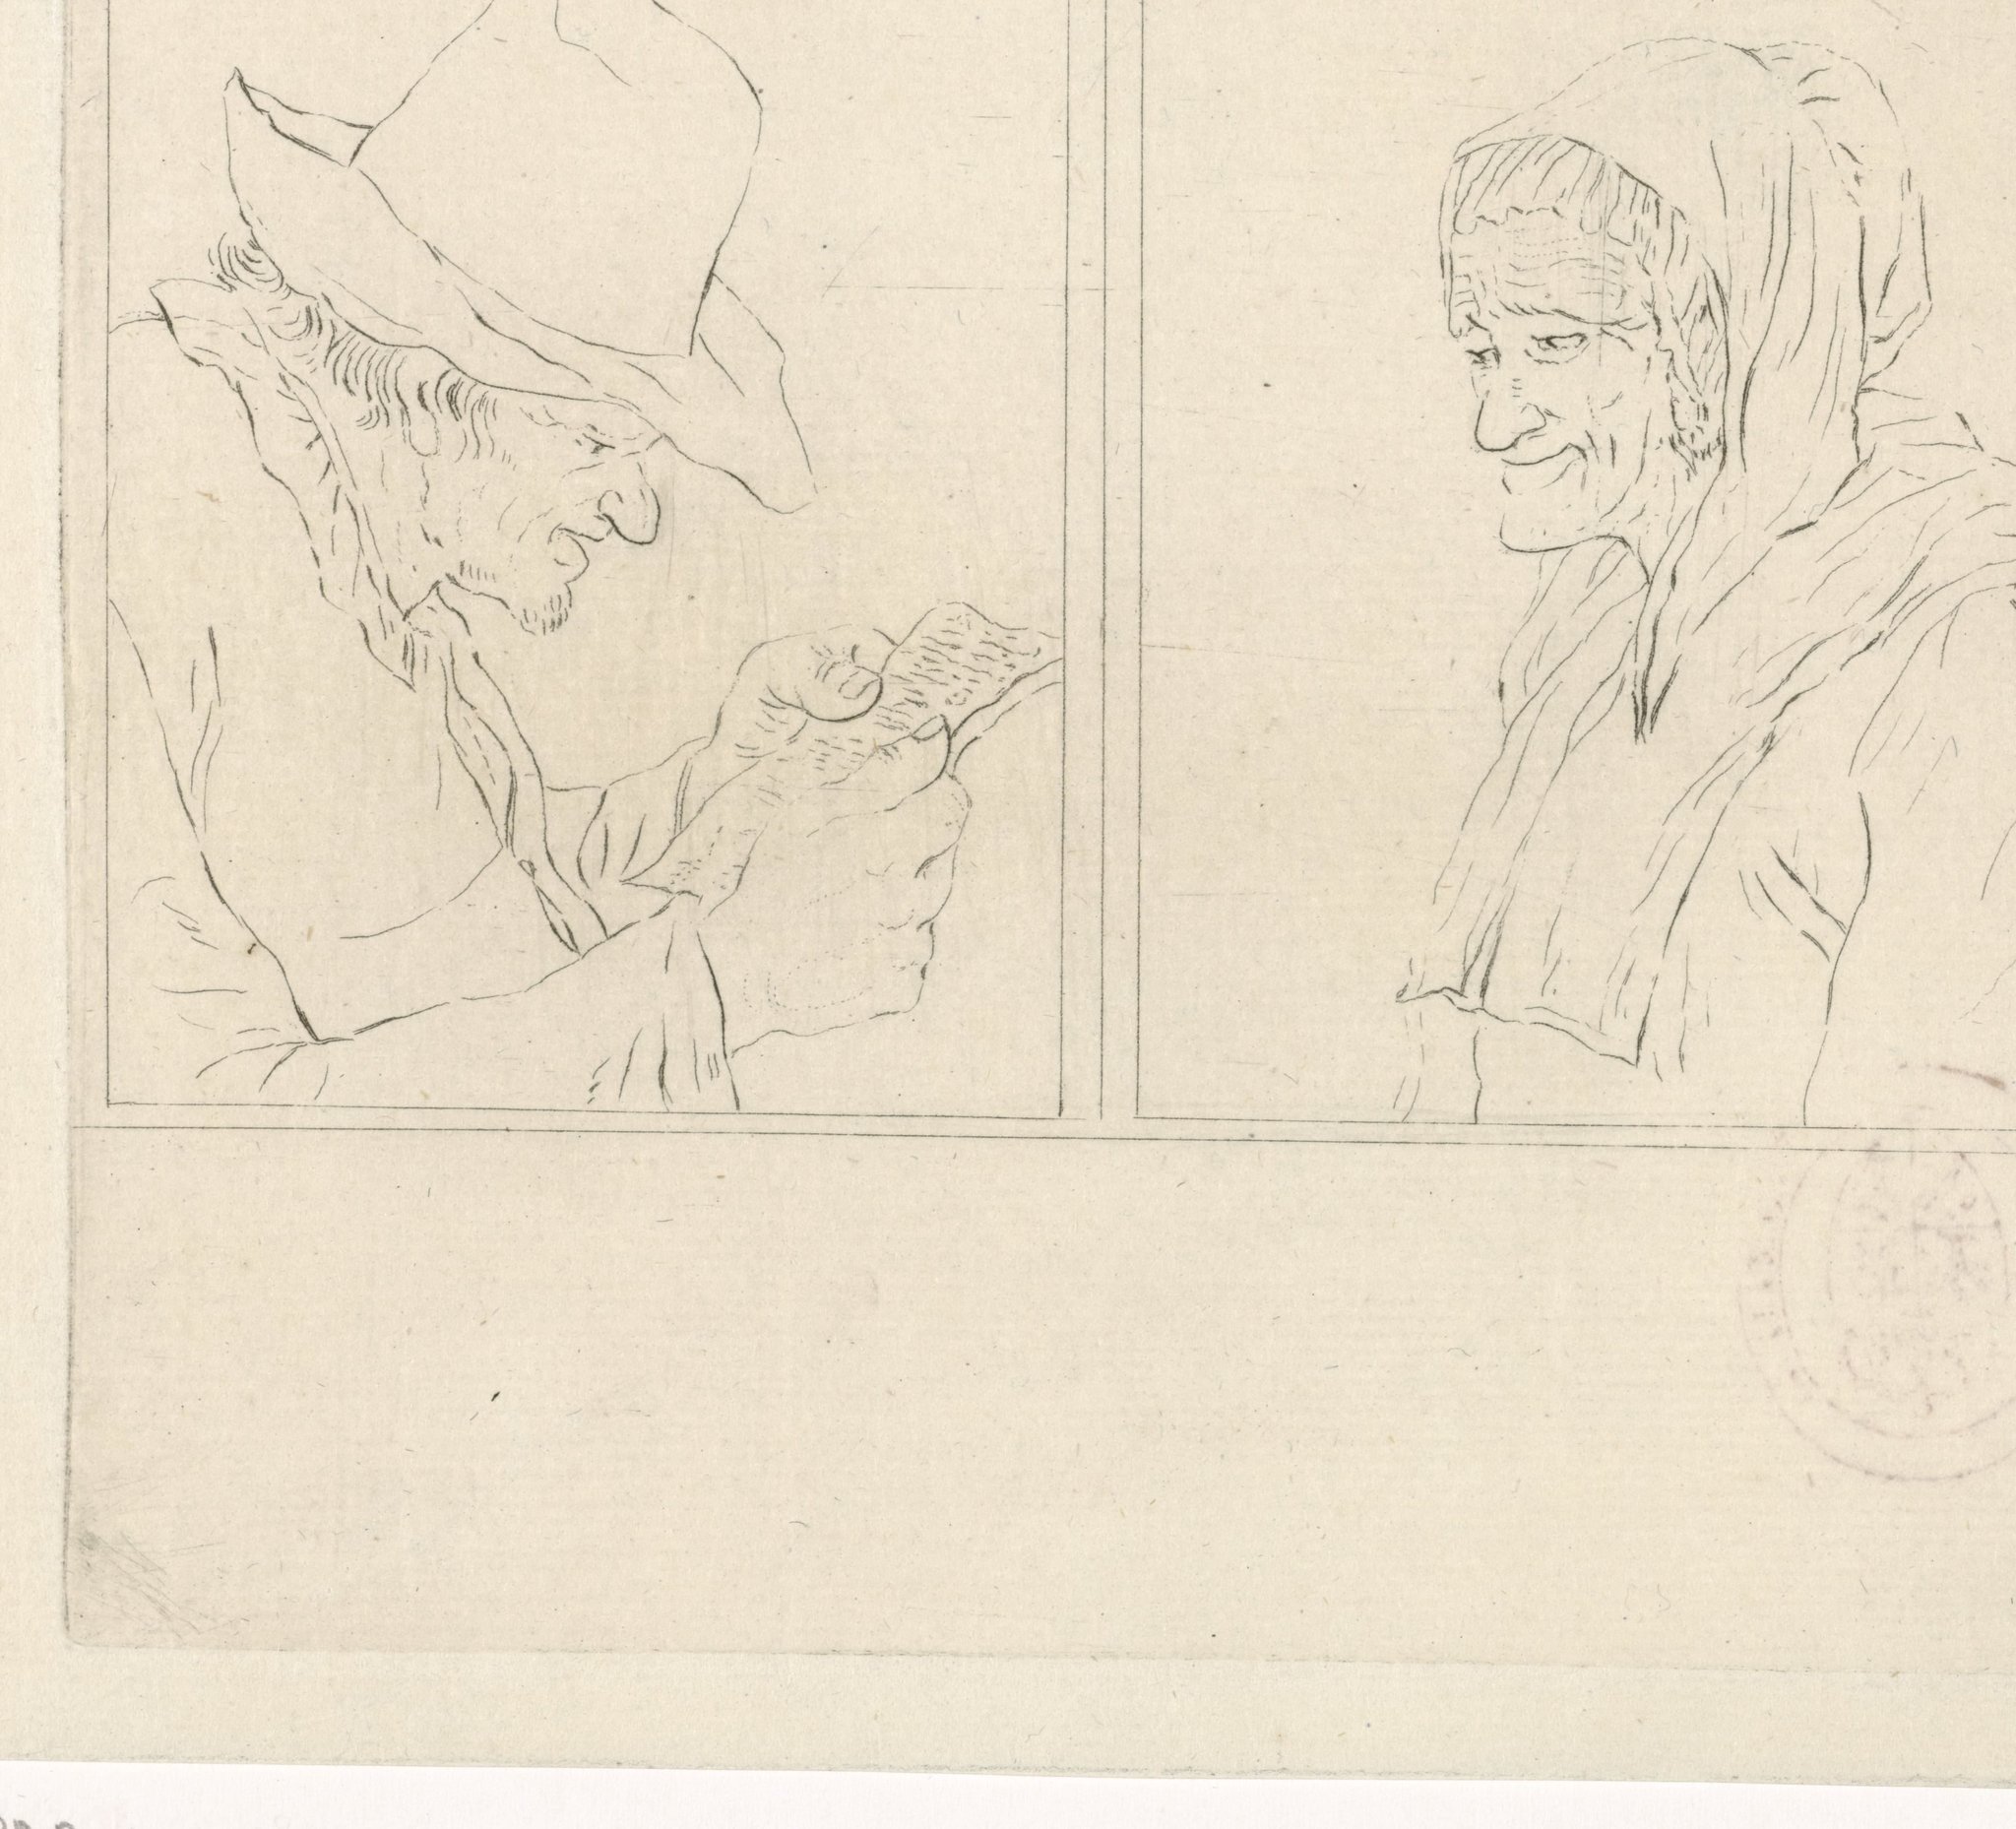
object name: print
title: Lezende man en oude vrouw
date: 1778-1796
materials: paper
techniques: etching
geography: leiden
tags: reading, old woman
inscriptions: collector's mark: Lugt 240